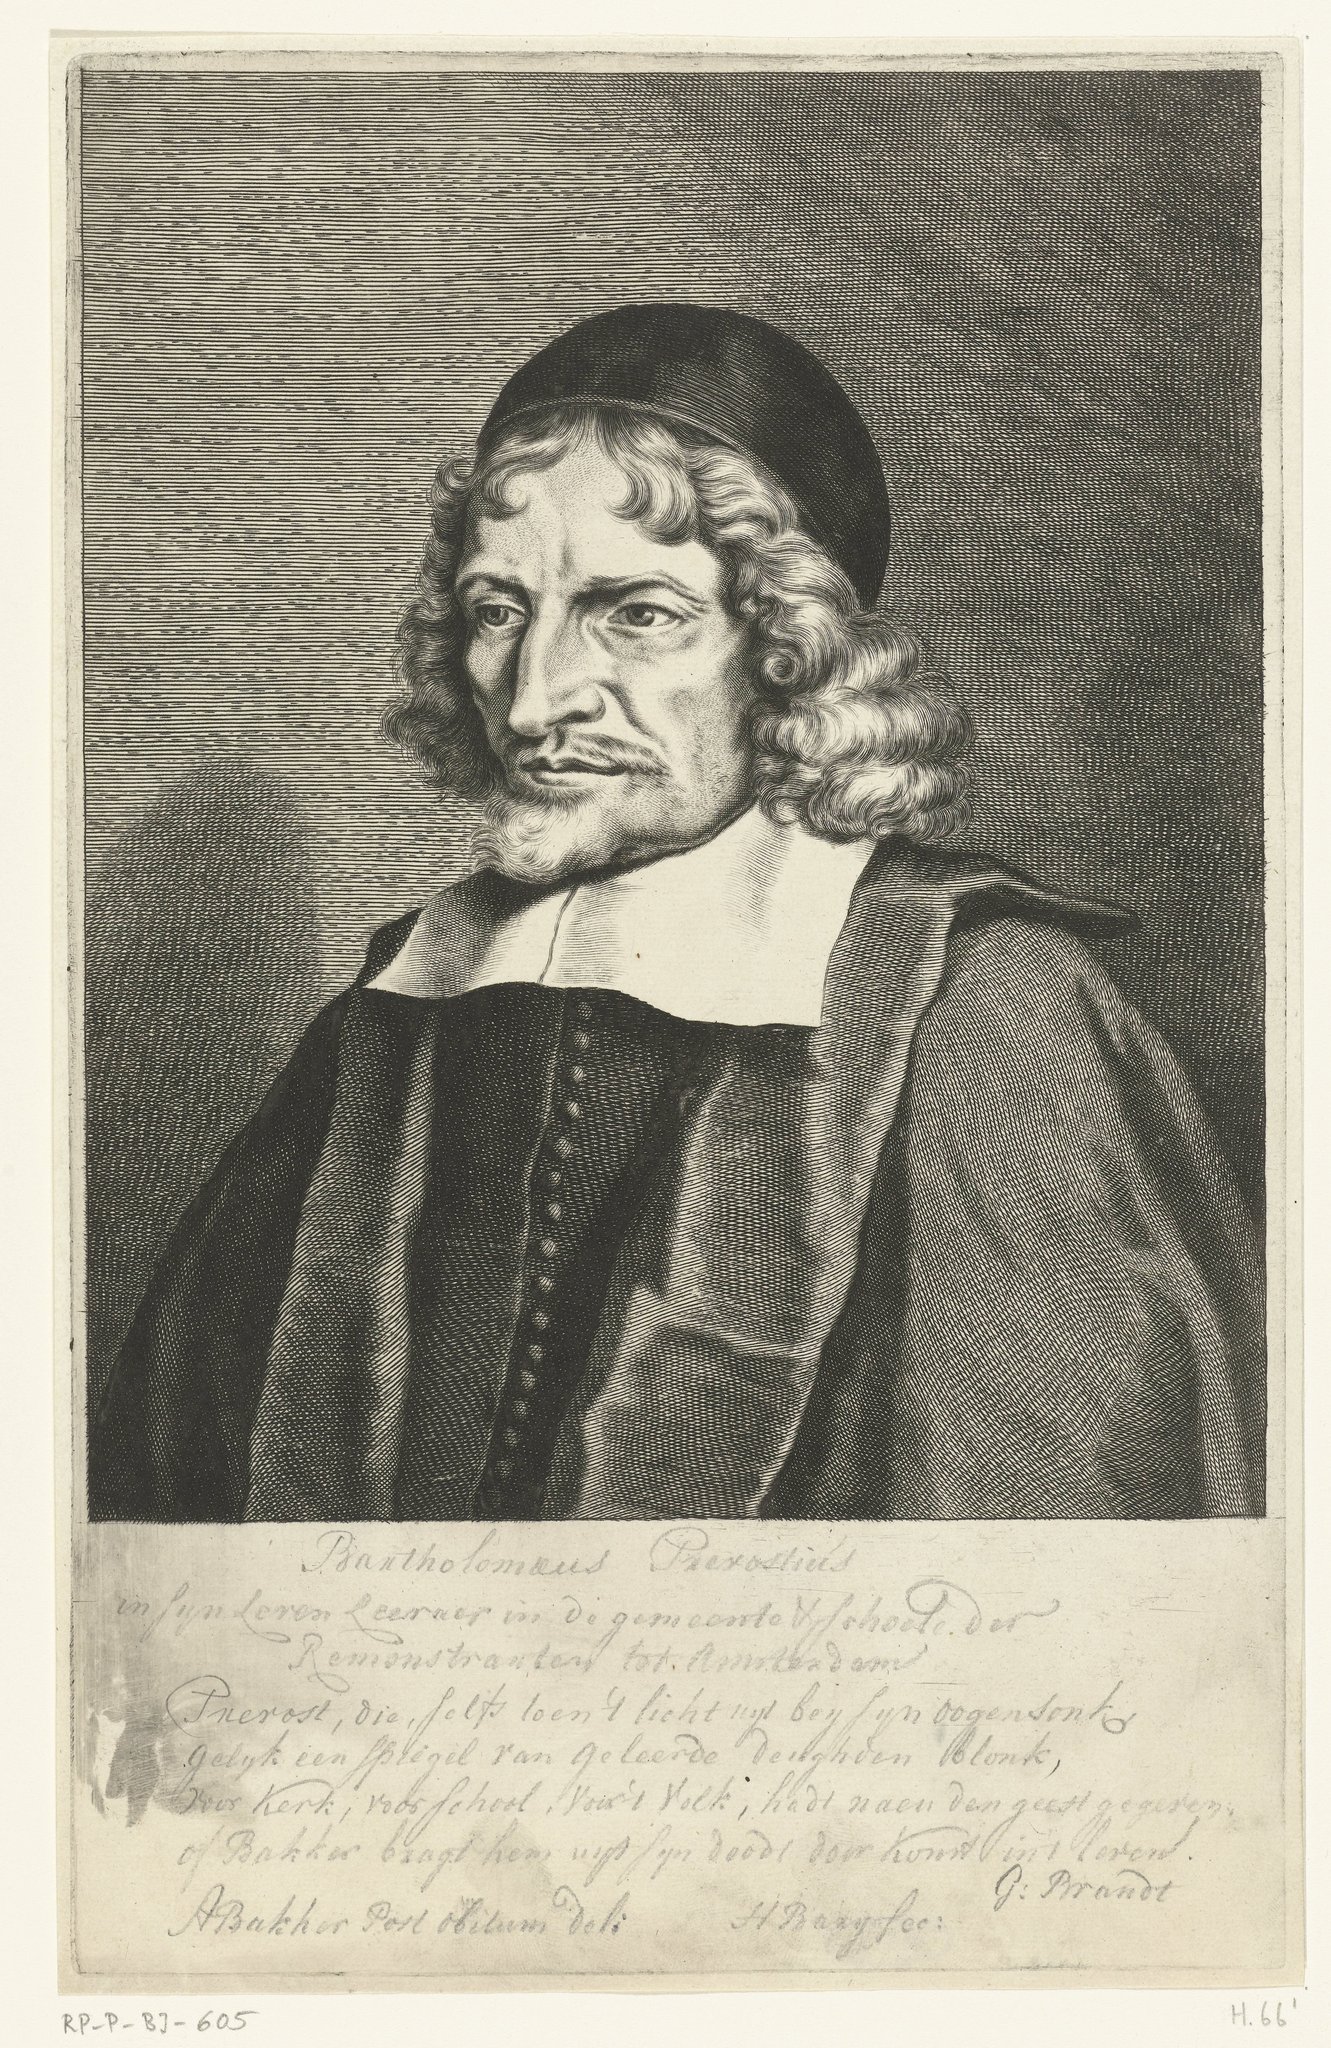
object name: print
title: Portret van Bartholomaeus Prevostius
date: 1657-1707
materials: graphite, paper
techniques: engraving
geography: netherlands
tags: bartholomaeus prevostius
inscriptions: collector's mark: Lugt 240, inscription: ‘Bartholomaeus Prevostius in syn leven leeraer in de gemeente [...] H Bary fec.’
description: Borstbeeld van de remonstrantse predikant Bartholomaeus Prevostius. Onder het portret een vers van G. Brandt in handschrift.